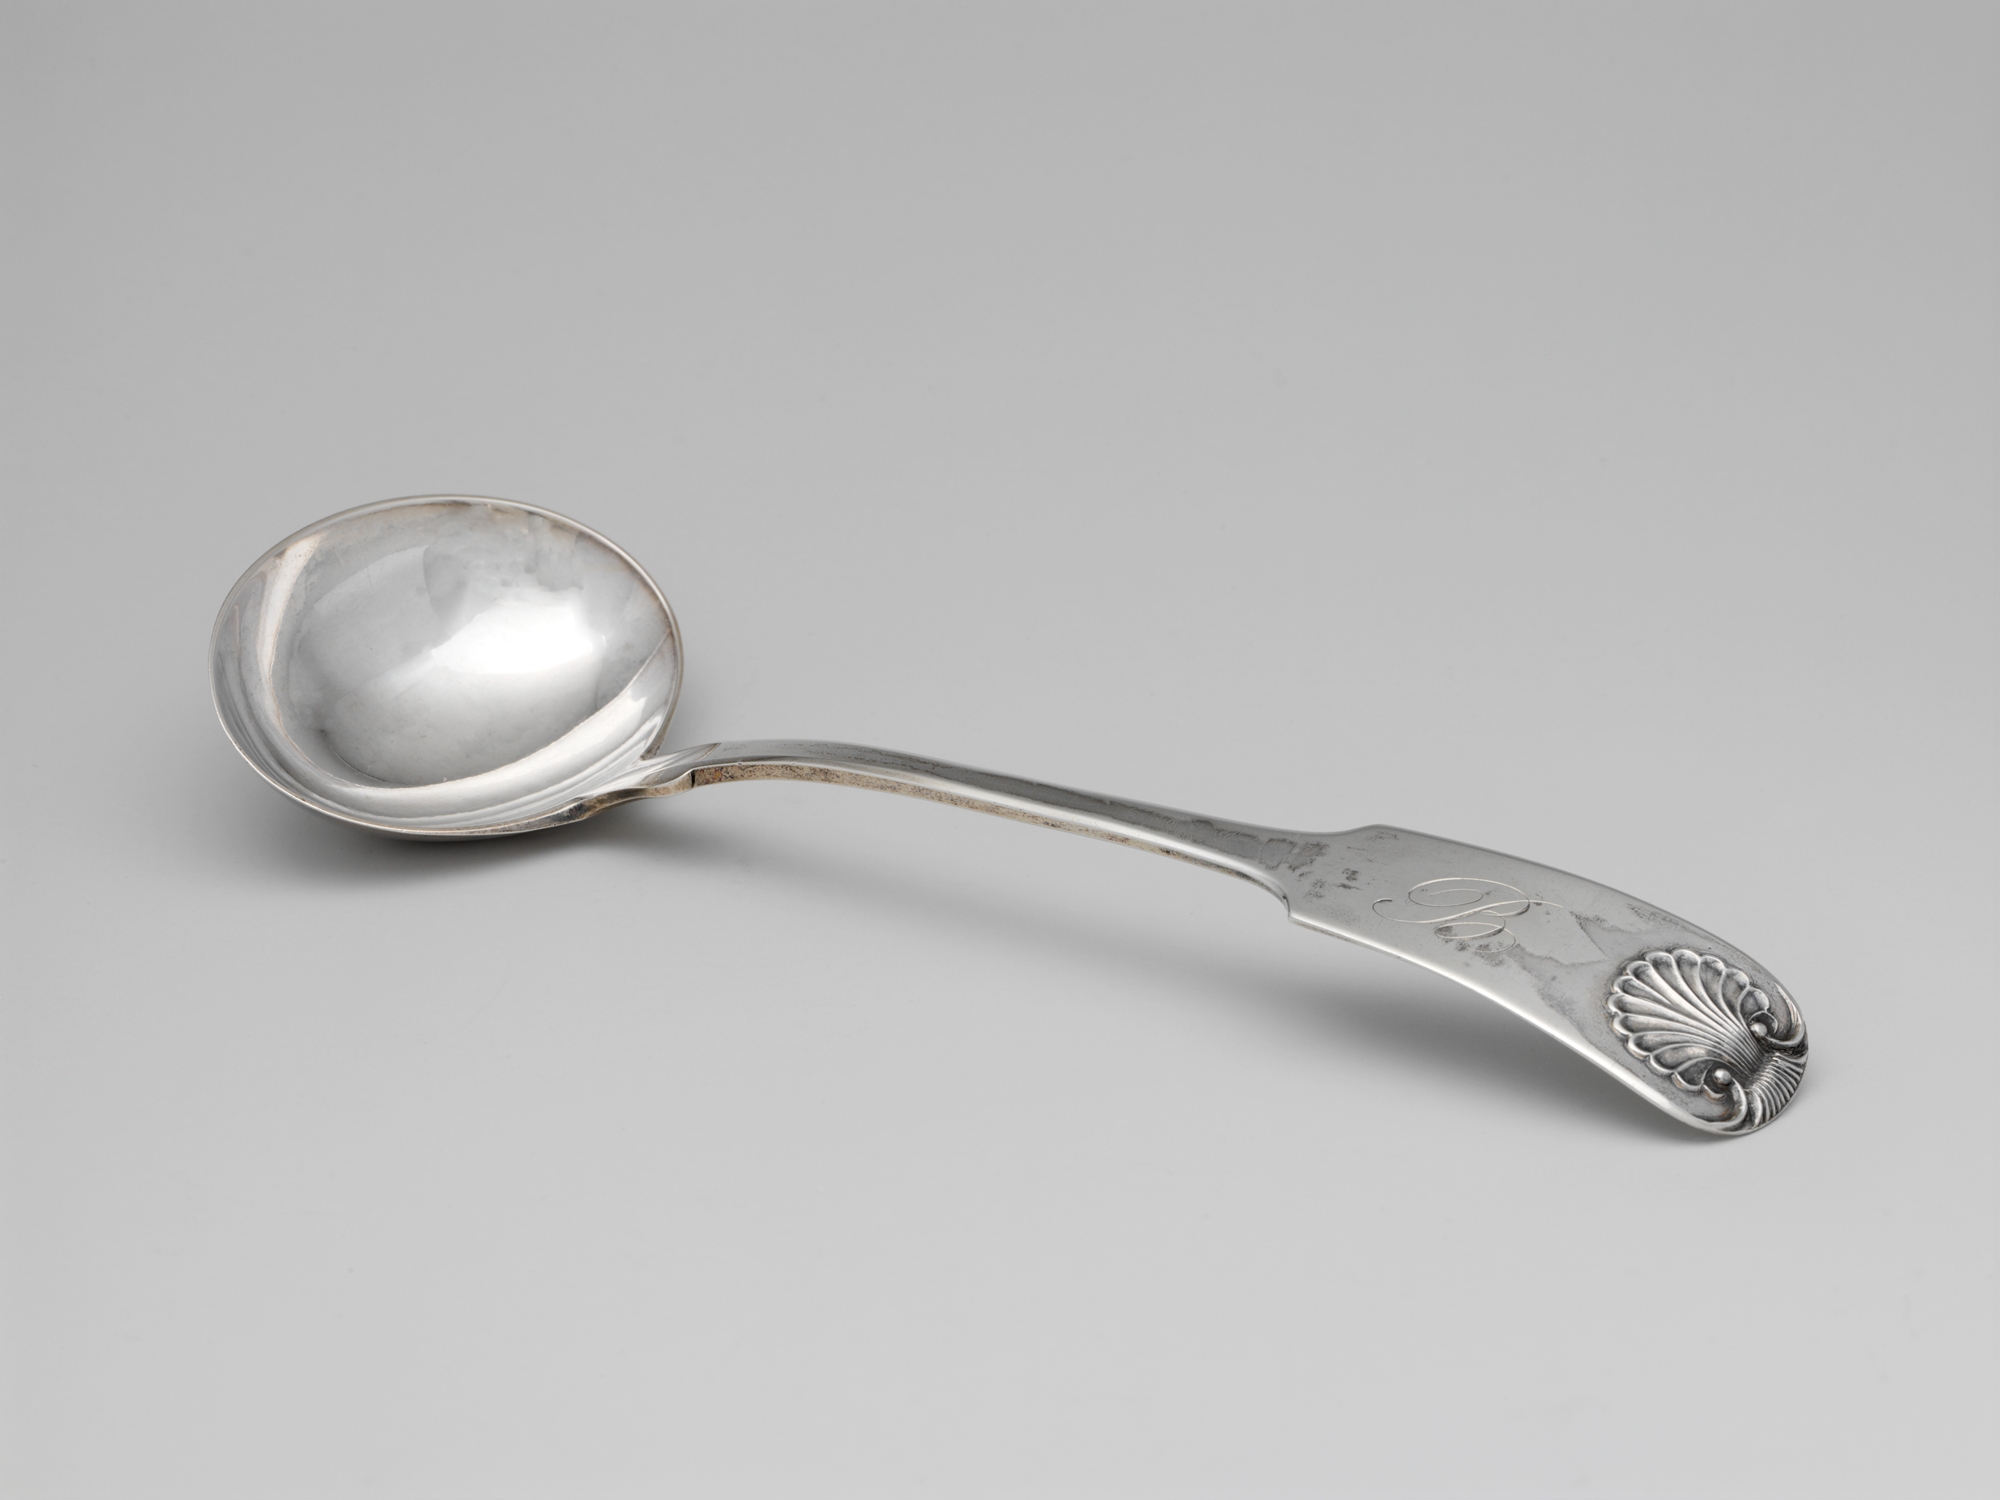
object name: ladle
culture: american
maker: james d. stout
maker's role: maker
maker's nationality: american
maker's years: 1802-1839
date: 1820-1830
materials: silver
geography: united states